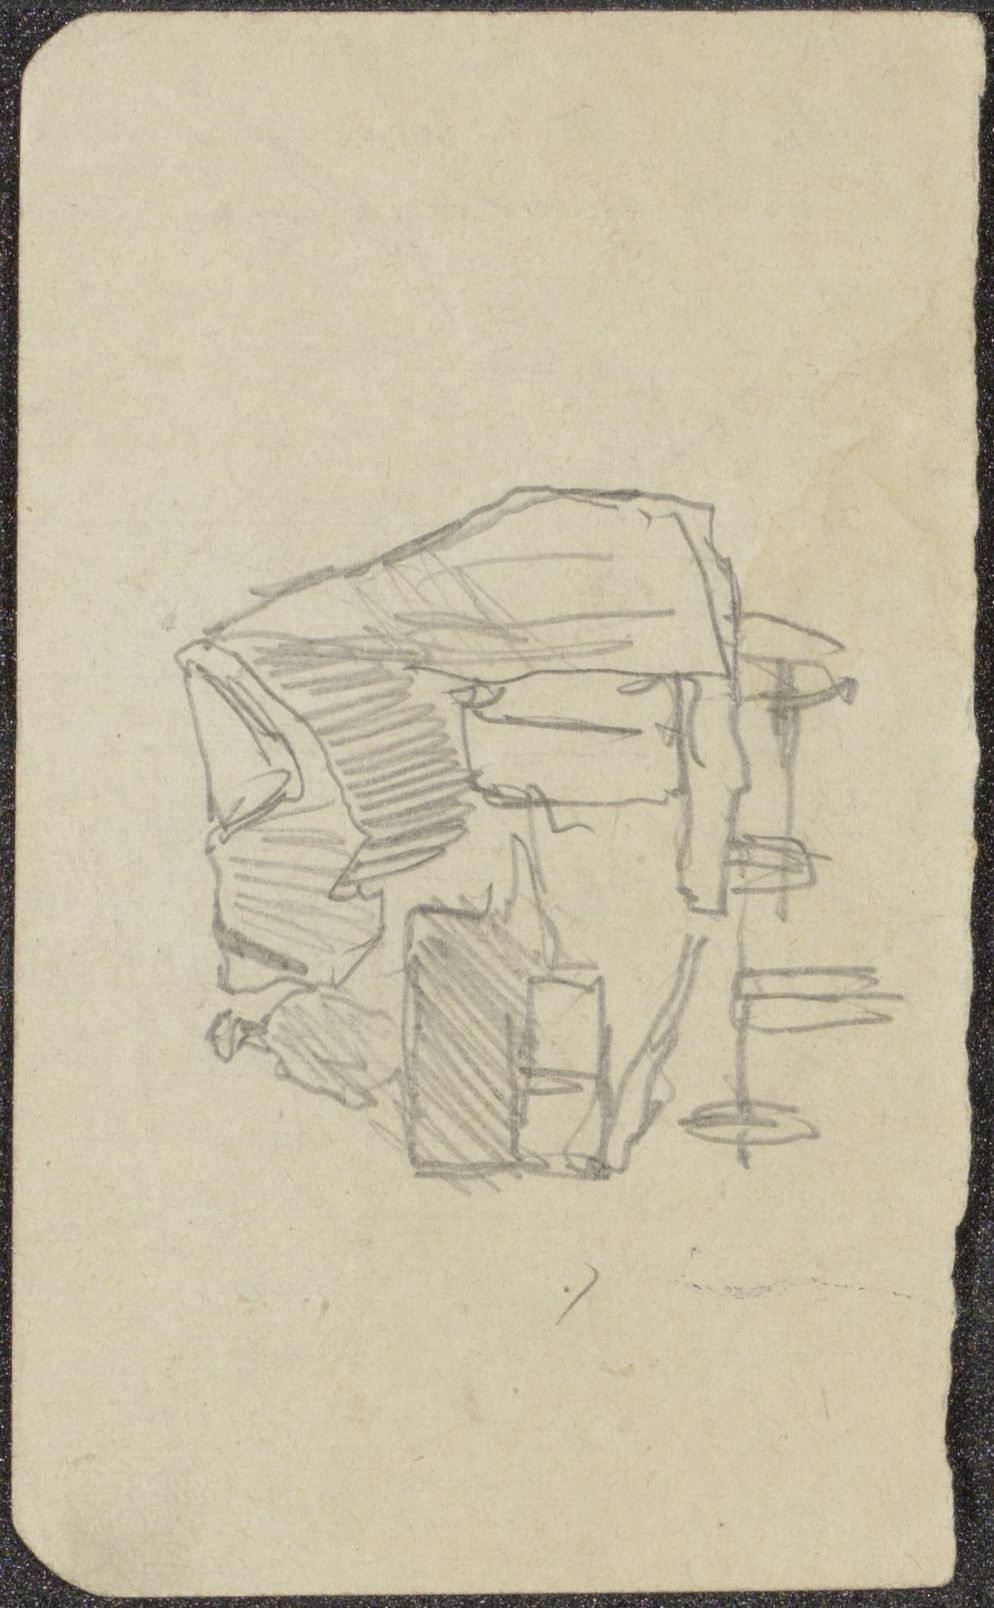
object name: drawing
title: Figuur op een zwaar beladen wagen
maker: george hendrik breitner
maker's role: draughtsman, painter, print maker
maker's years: 1857-1923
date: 1873-1923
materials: paper, pencil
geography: netherlands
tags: (farm) wagon, freight wagon, cart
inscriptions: annotation: ‘Hulsmann/ Weesperzijde 123/ M[...]straat 283/ Stumphuis/ Weteringschans 84b/ [...]/ Carolina/ Jordan [...]/ Wiesbaden/ Friedrich Philip/ Gottfried/ [...]/ Amalia [...]’